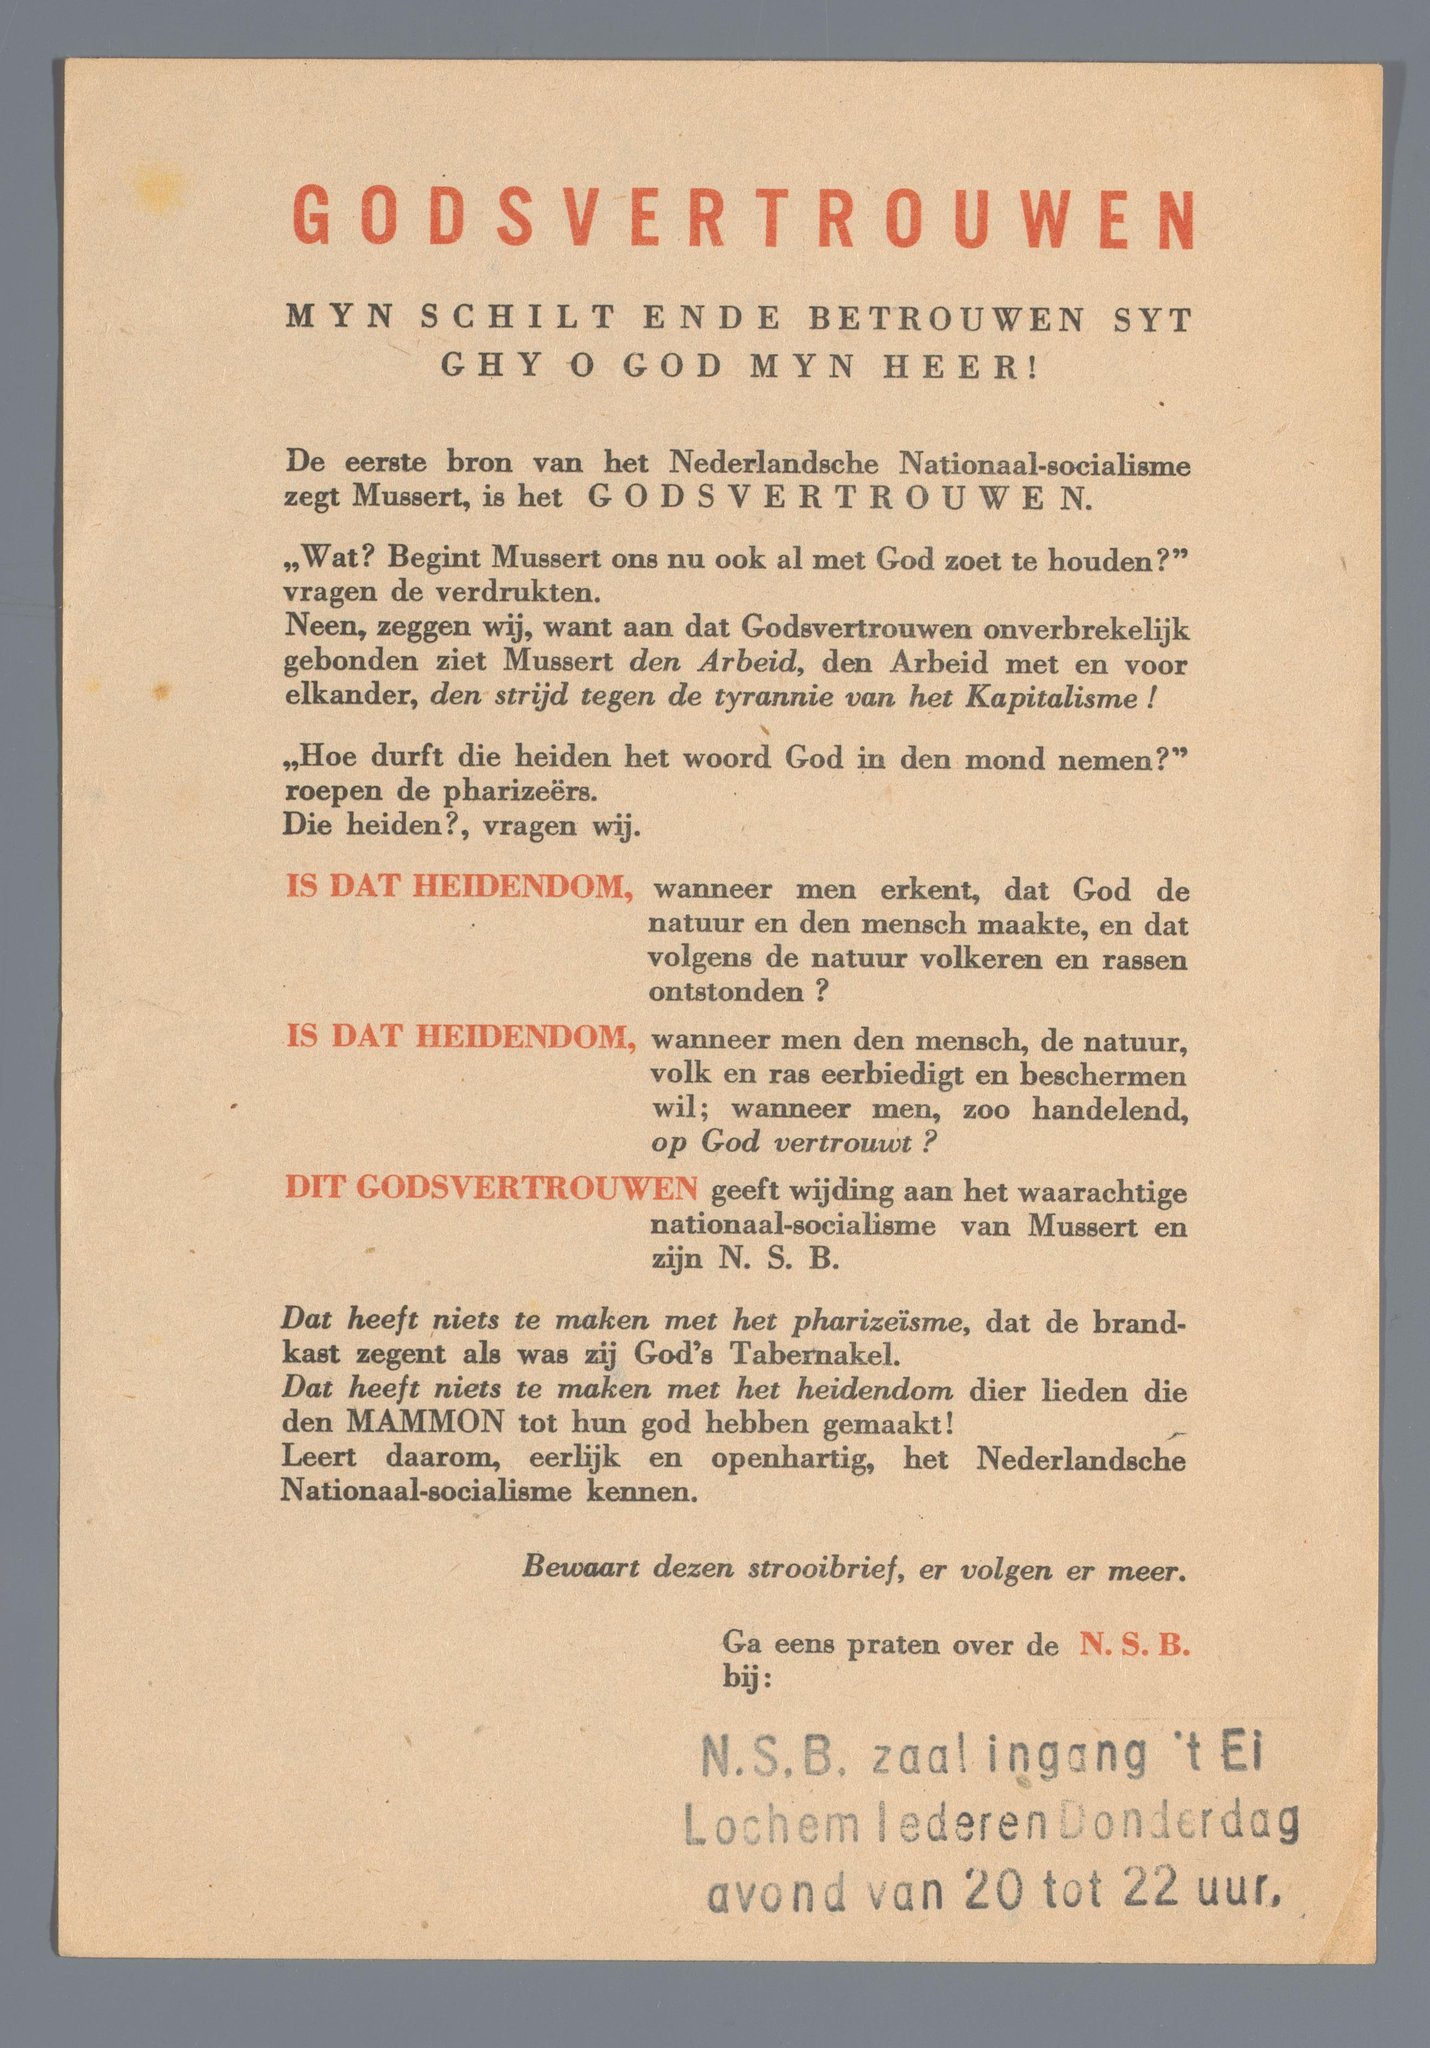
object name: pamphlet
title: Godsvertrouwen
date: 1940-1945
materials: paper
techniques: printing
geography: lochem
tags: politieke partij, nsb, lochem, tweede wereldoorlog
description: Eénzijdig bedrukt blad papier, in zwart en rood, met stempel rechtsonder "N.S.B. zaal ingang 't Ei/Lochem Iederen Donderdag avond van 20 tot 22 uur".